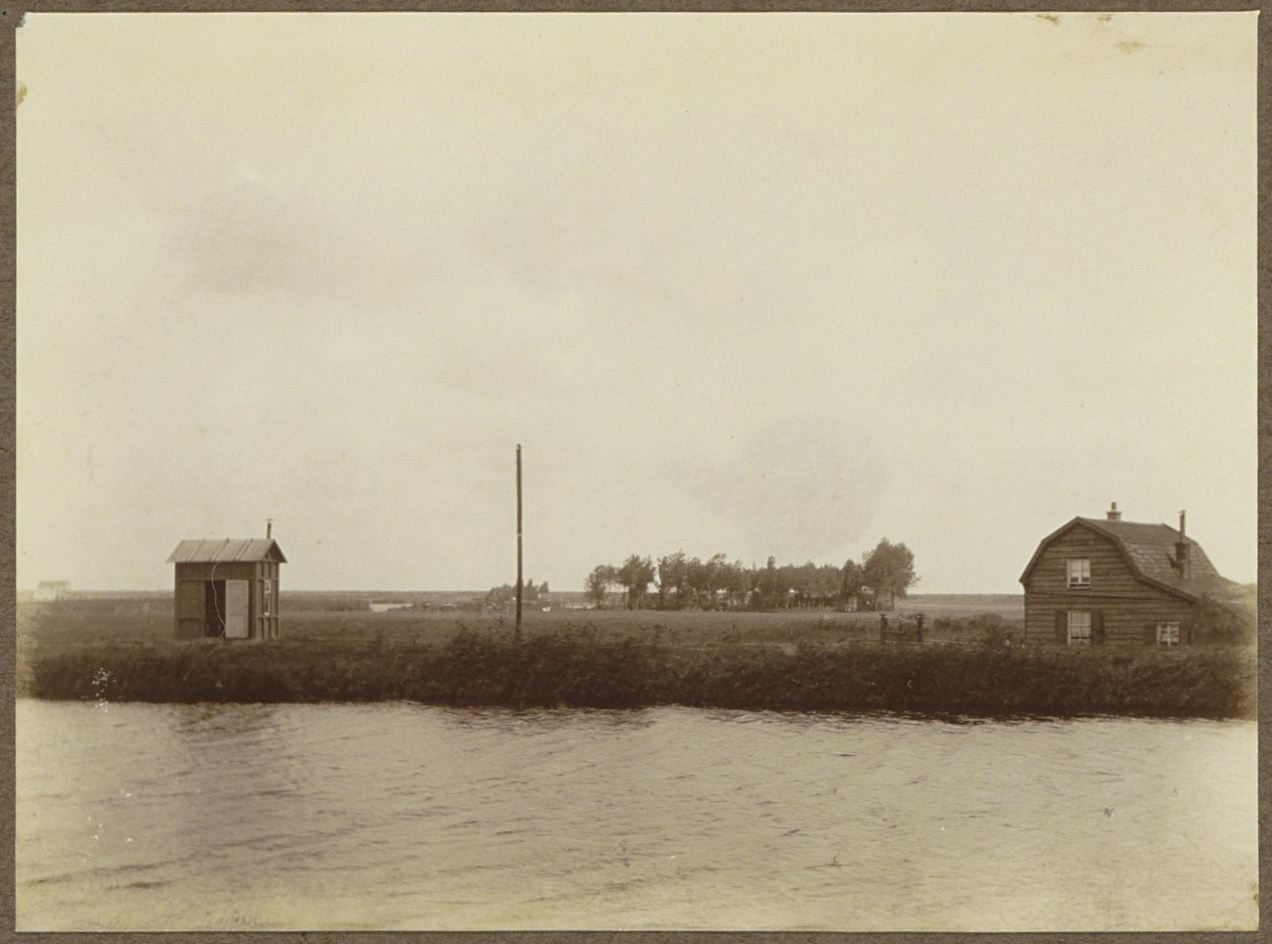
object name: photograph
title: Huizen aan het water achter Oud-Diemen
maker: Anonymous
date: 1910-1930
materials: paper, photographic support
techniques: daylight paper print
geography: diemen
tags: rural housing, e.g. country-house, villa, cottage, brook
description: Onderdeel van Album met foto's van Amsterdam en omgeving.